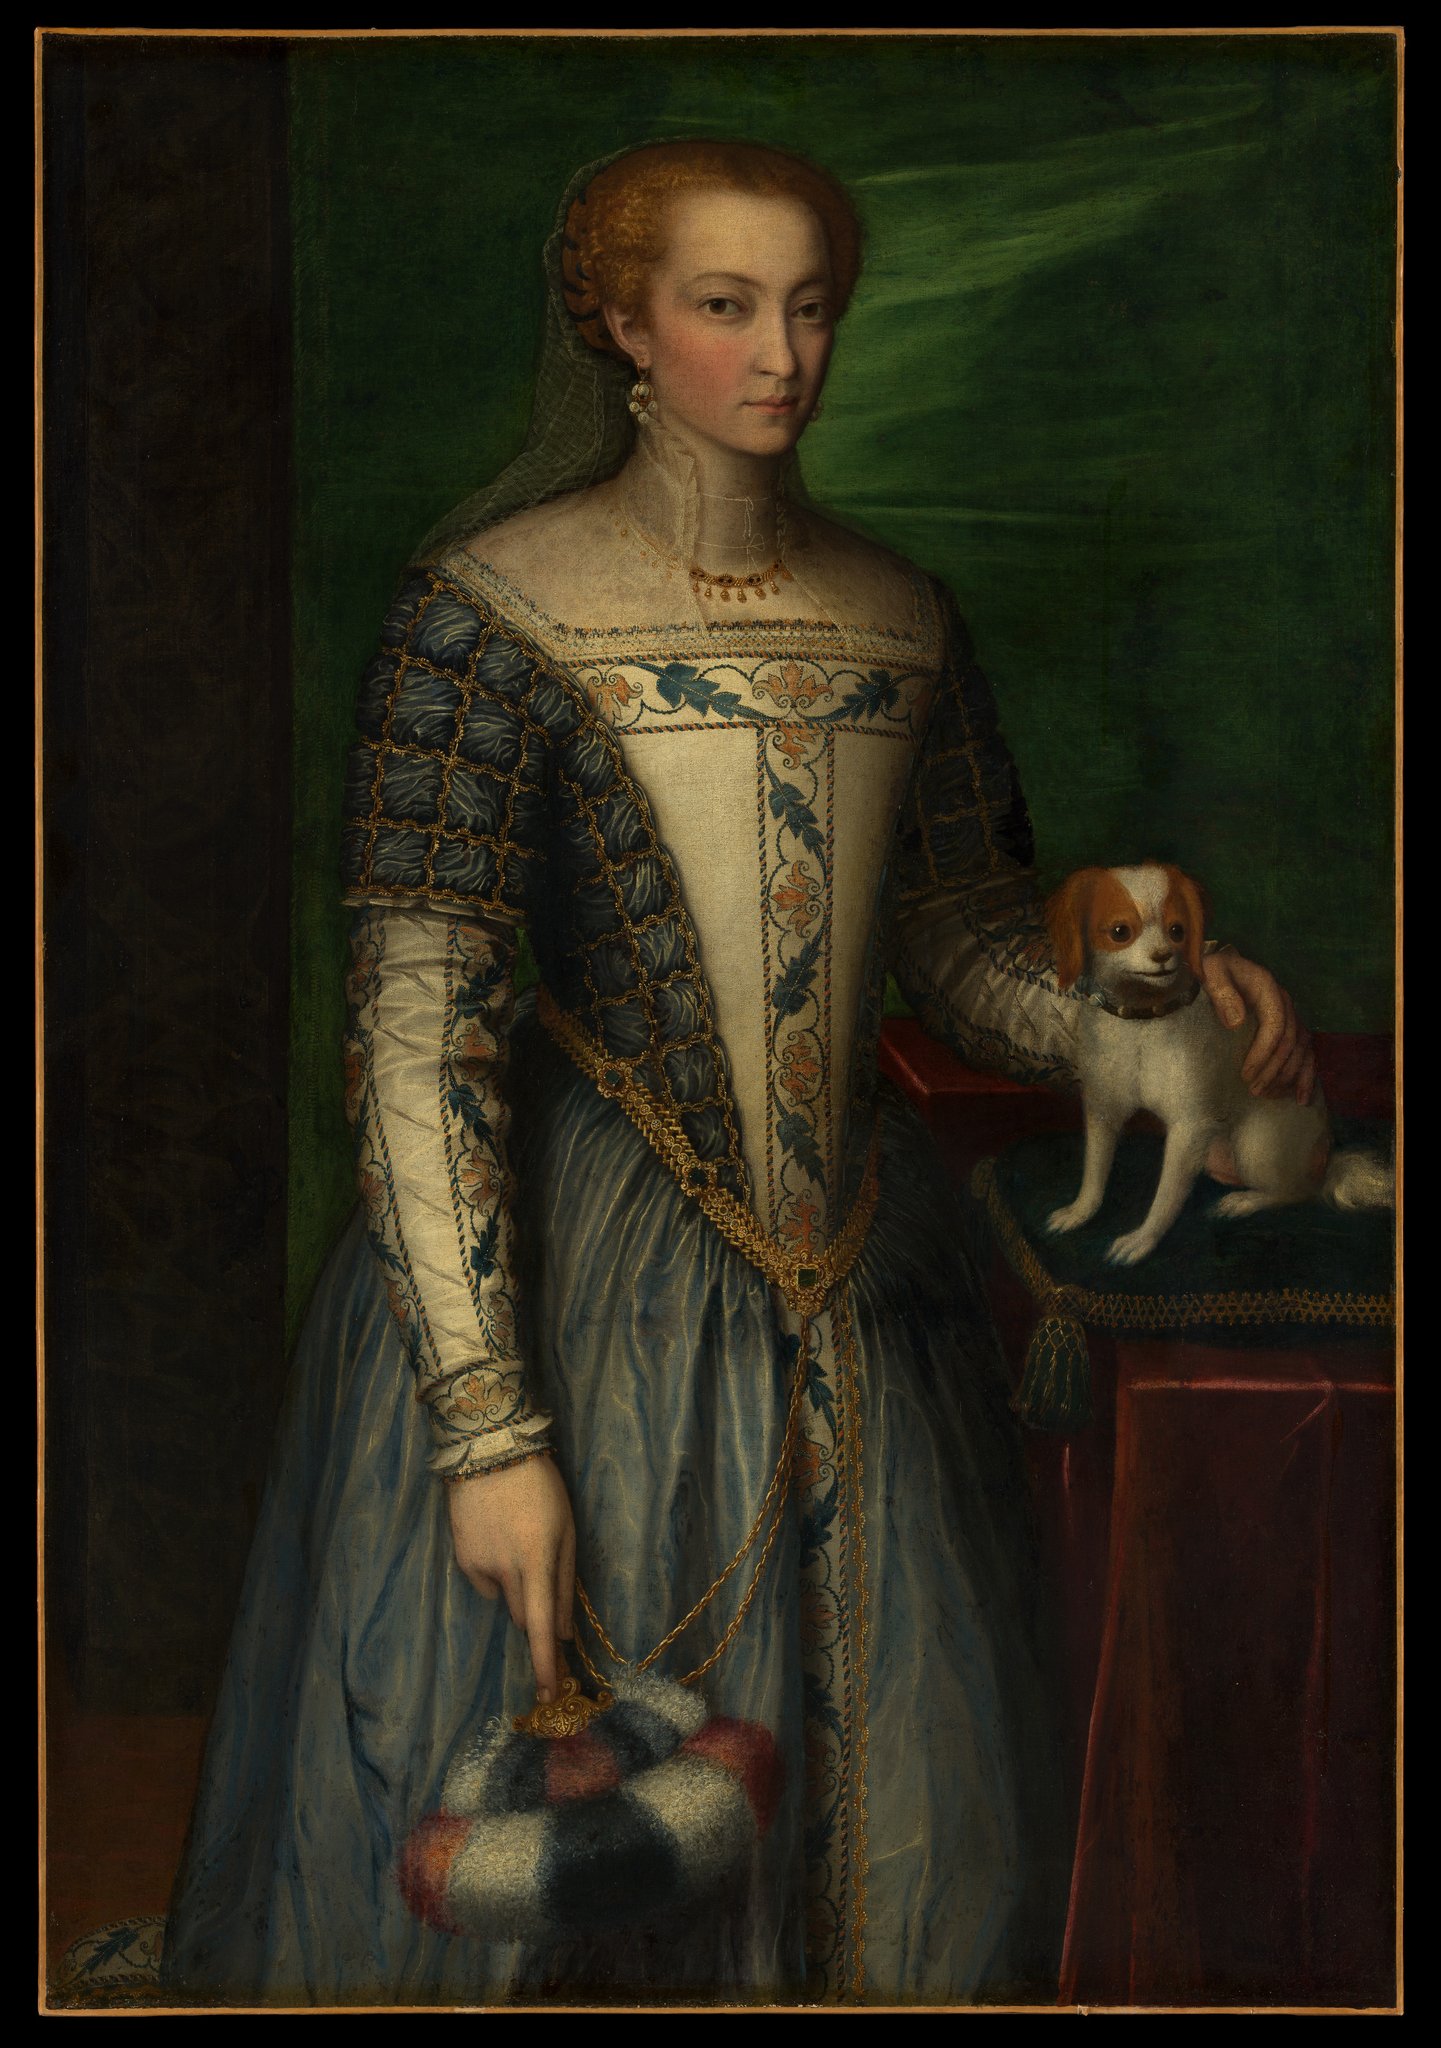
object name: painting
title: Portrait of a Woman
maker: bernardino campi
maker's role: artist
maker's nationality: italian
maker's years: 1522-1591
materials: canvas, oil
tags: portraits,women,dogs